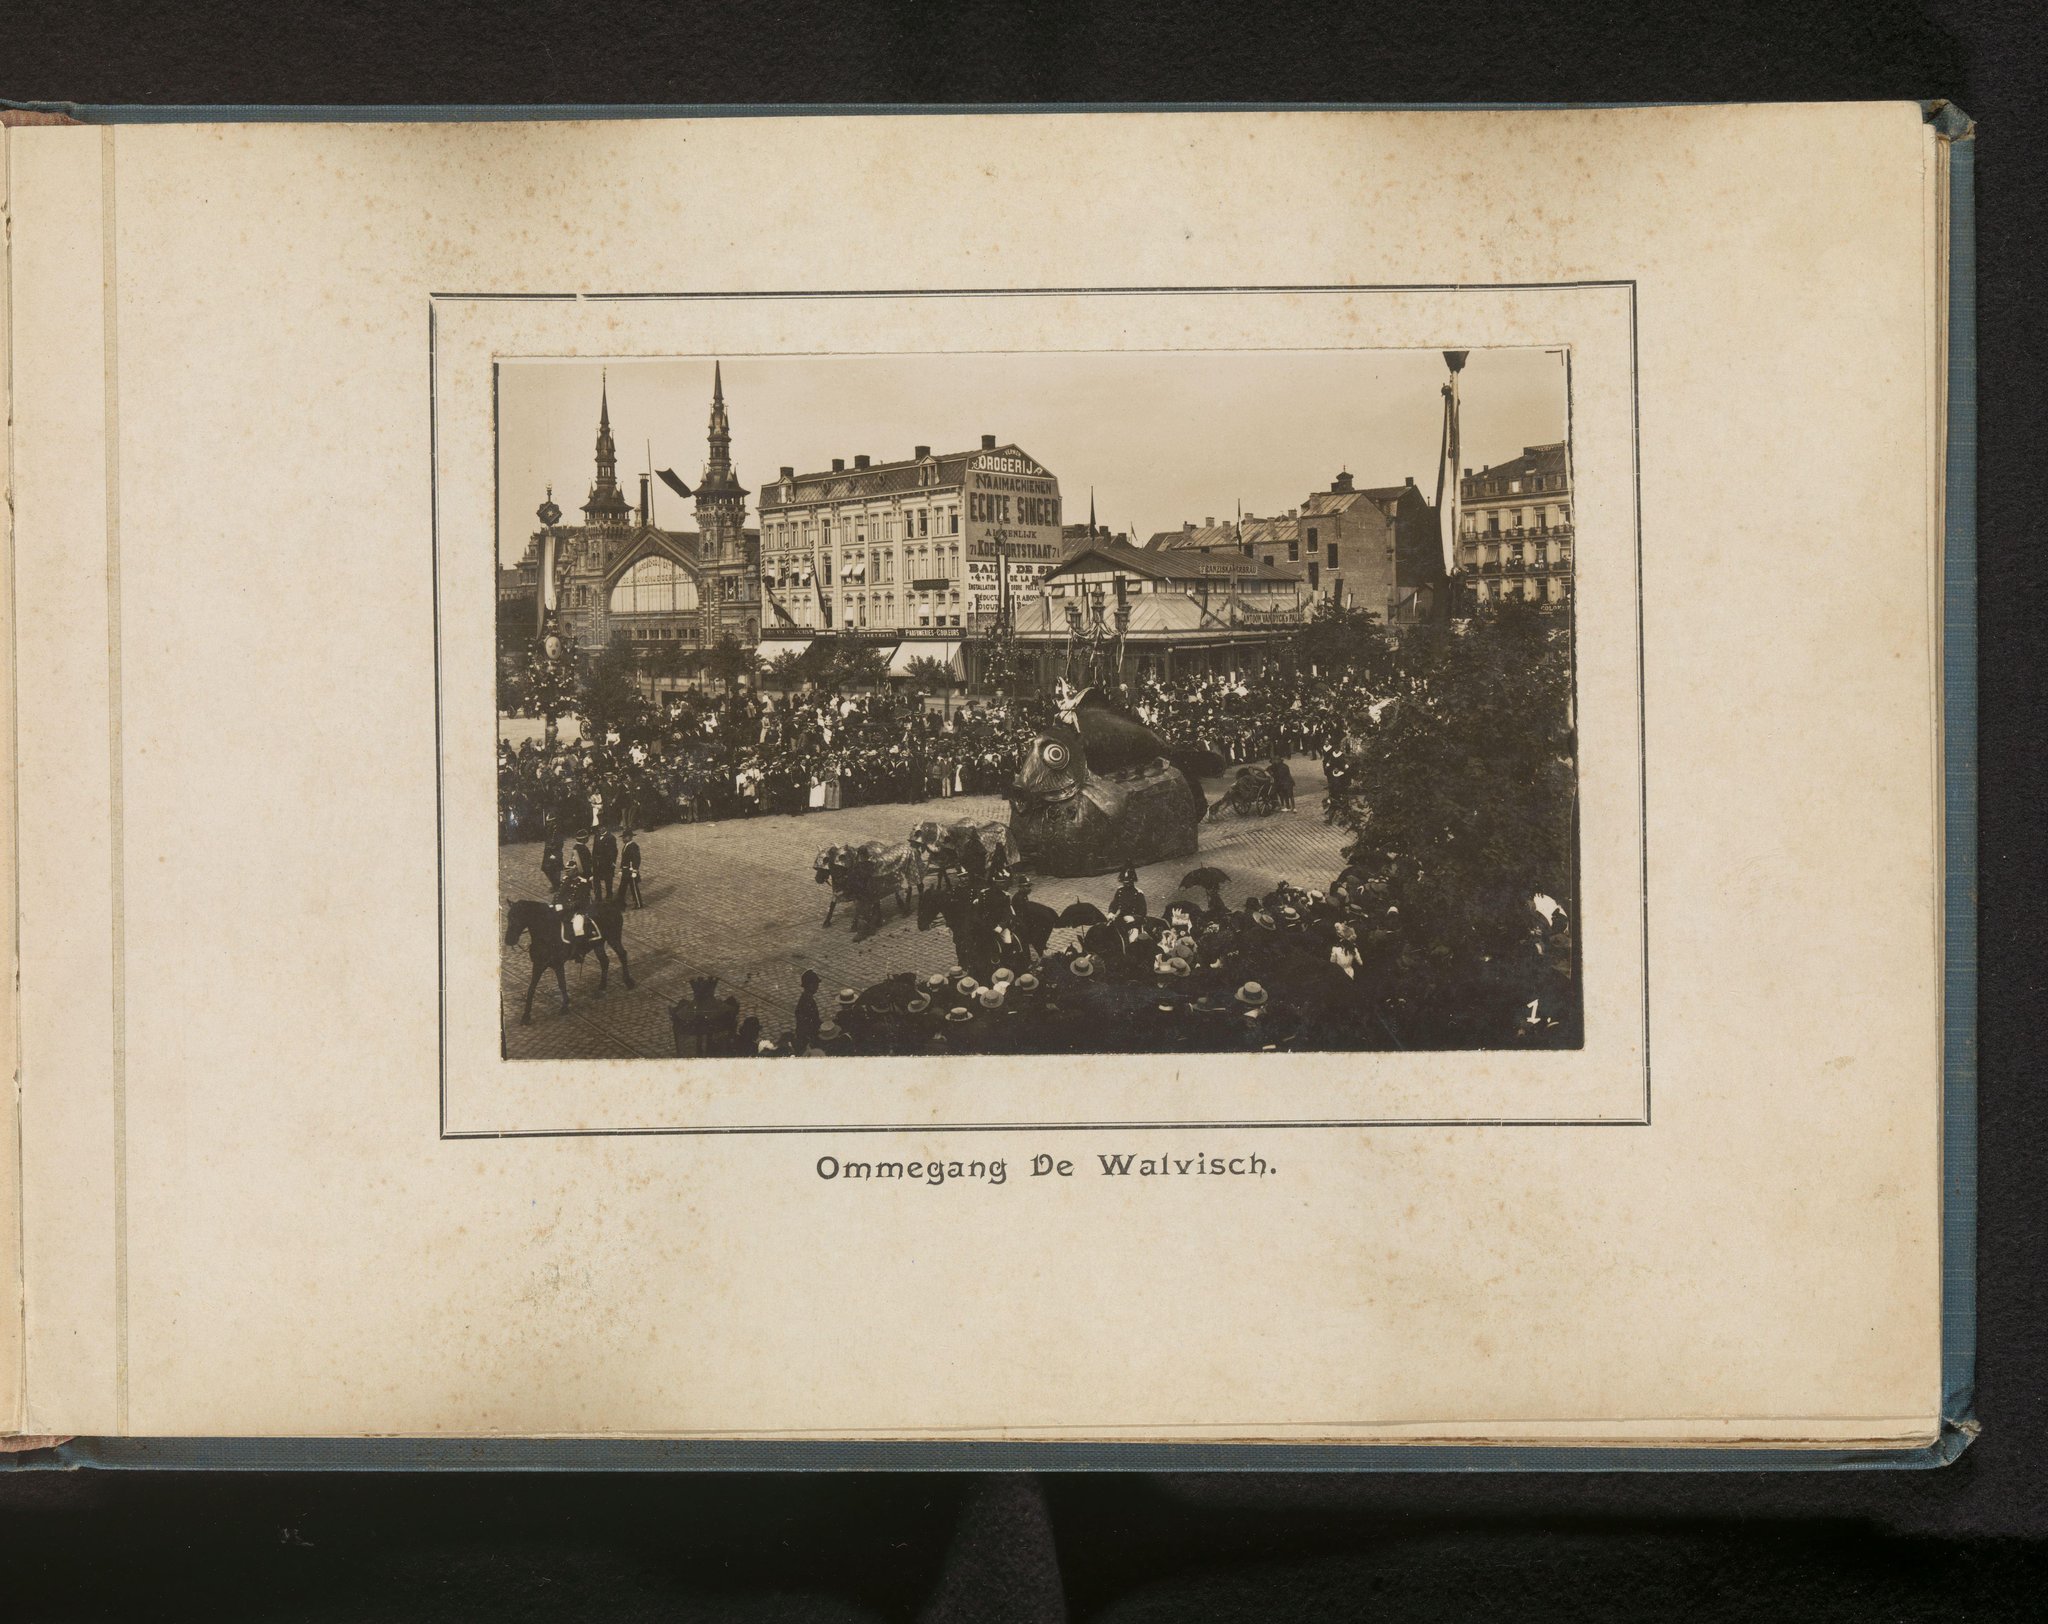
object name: photograph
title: Ommegang de walvisch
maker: Anonymous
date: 1899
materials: photographic support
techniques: printing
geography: antwerp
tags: animal traction, animal-drawn vehicle (carriage etc.), festivities (+ decorated float, wagon ~ festive activities), civic architecture; edifices; dwellings, antwerp